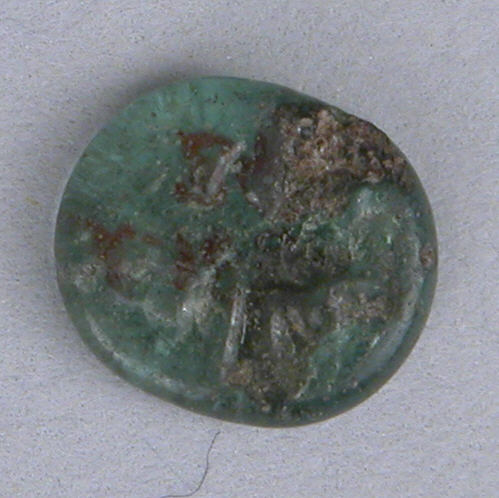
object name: coin weight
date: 1001-1100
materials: glass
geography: egypt